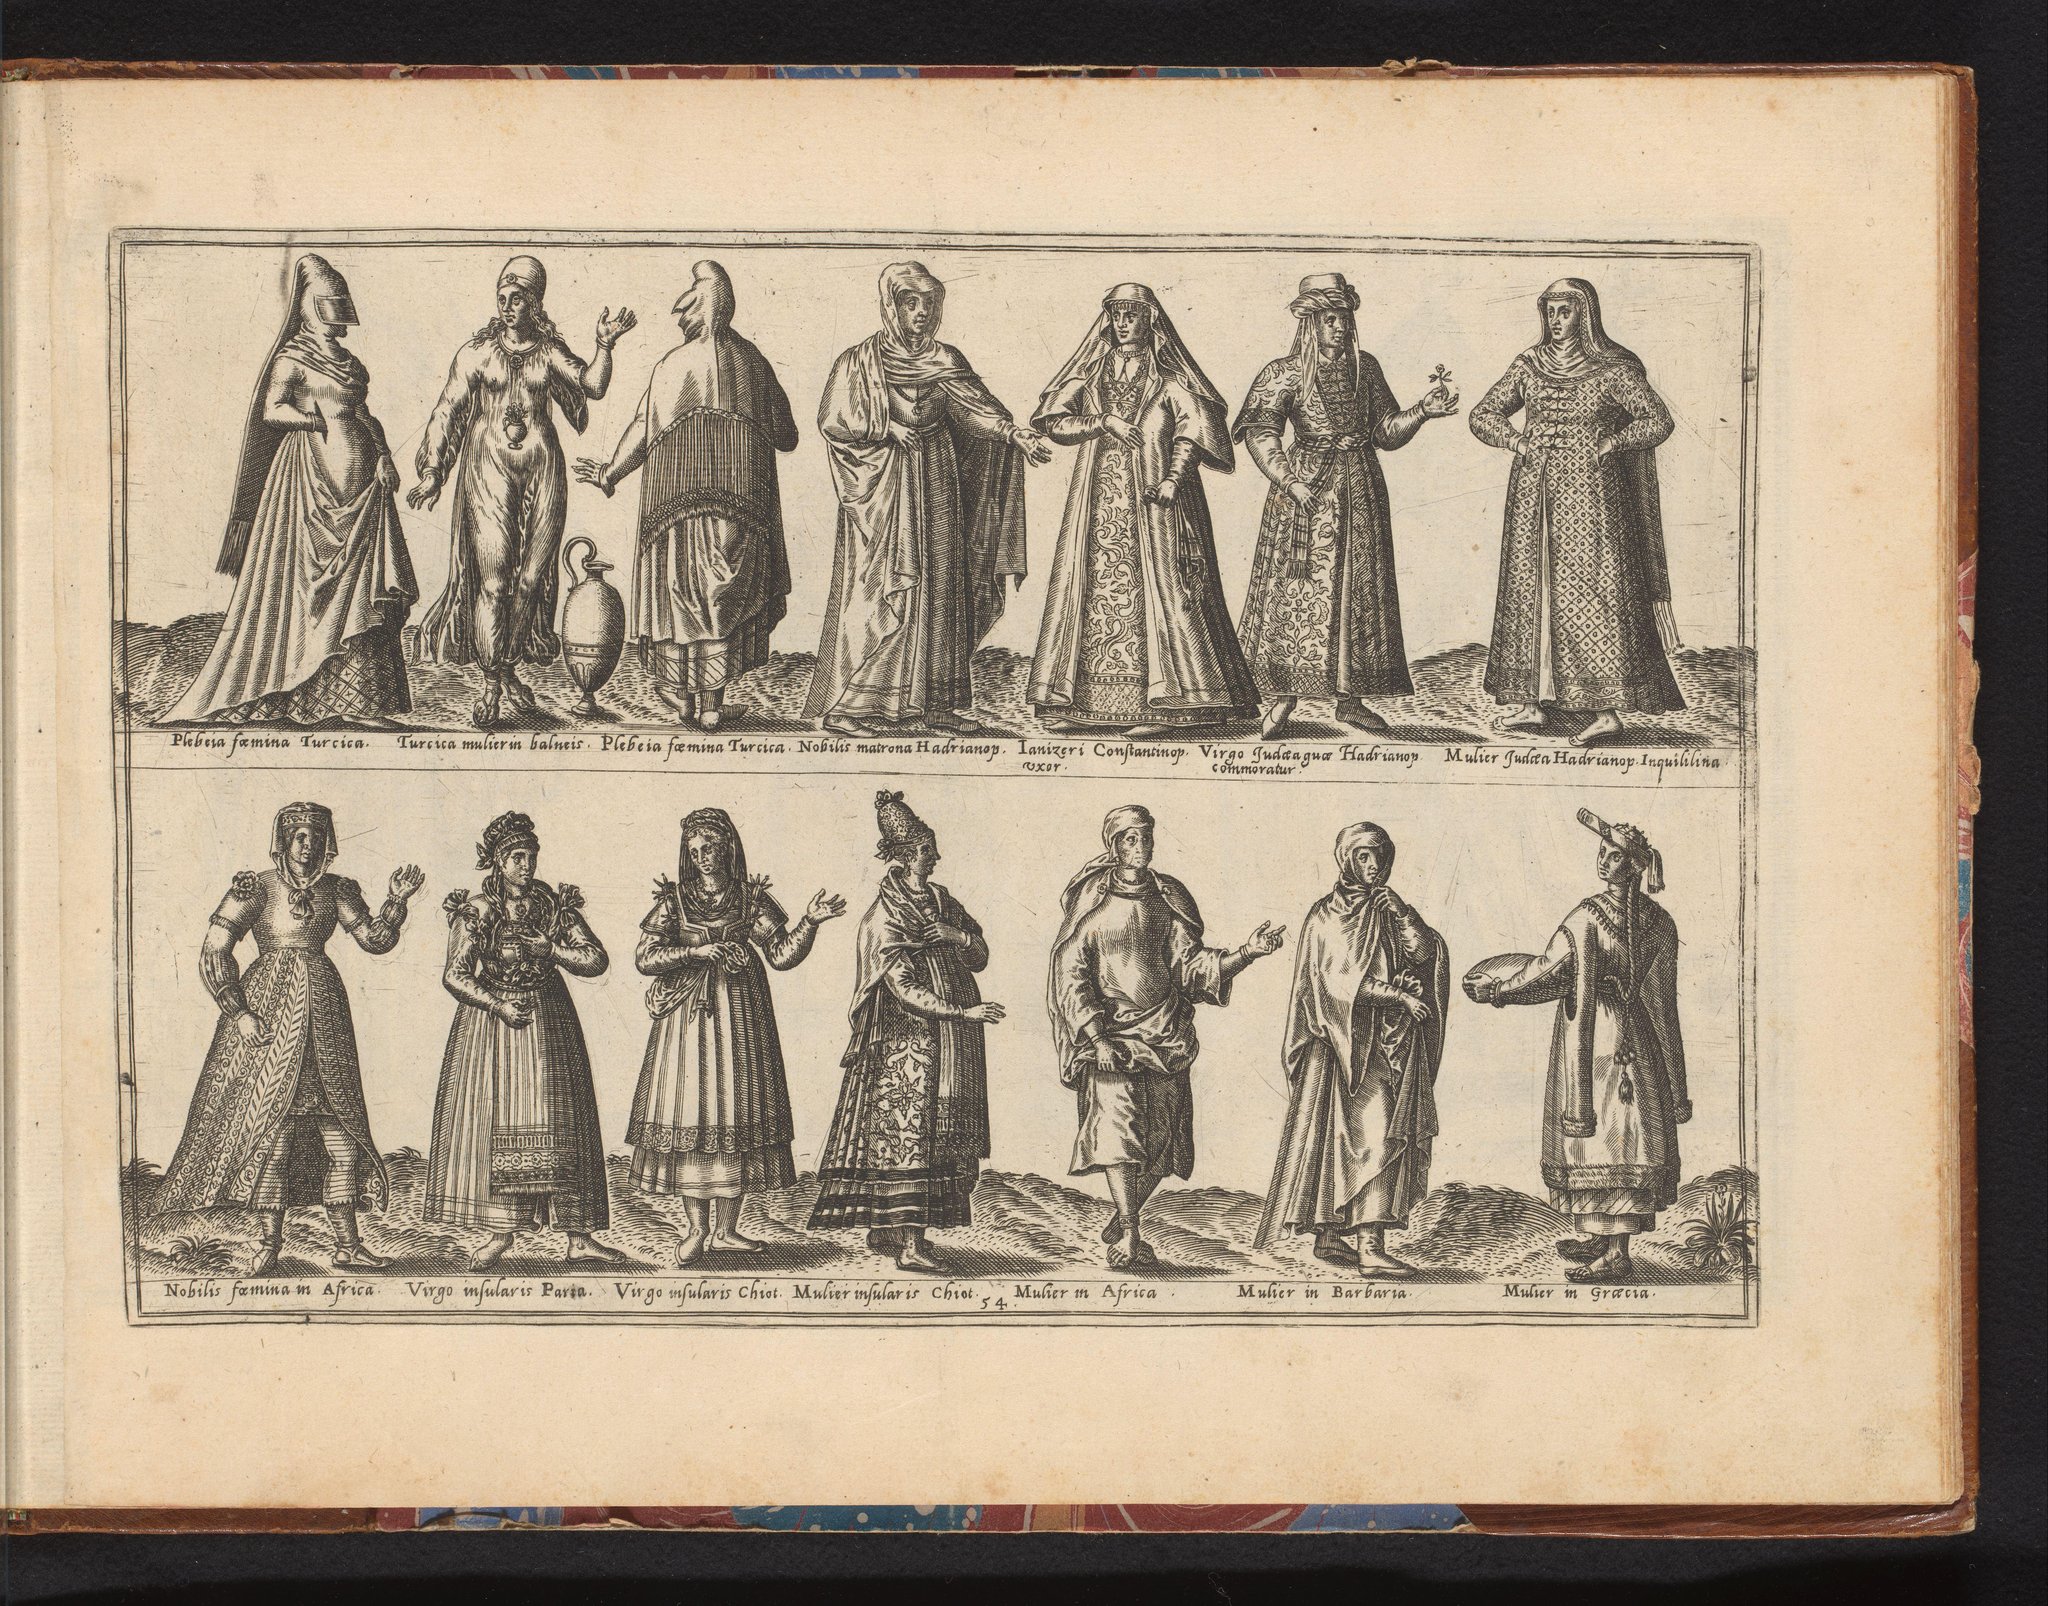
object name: album leaf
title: Veertien Afrikaanse en Aziatische vrouwen, gekleed volgens de dracht van ca. 1580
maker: abraham de bruyn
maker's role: print maker, publisher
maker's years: 1540-1587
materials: paper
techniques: engraving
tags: africans (+ costume), asiatic races and peoples (+ costume)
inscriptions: number: ‘54’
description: Prent uit het boek 'Omnium pene Europae, Asiae, Aphricae atque Americae gentium habitus...', 1581. De prent maakt deel uit van een album.